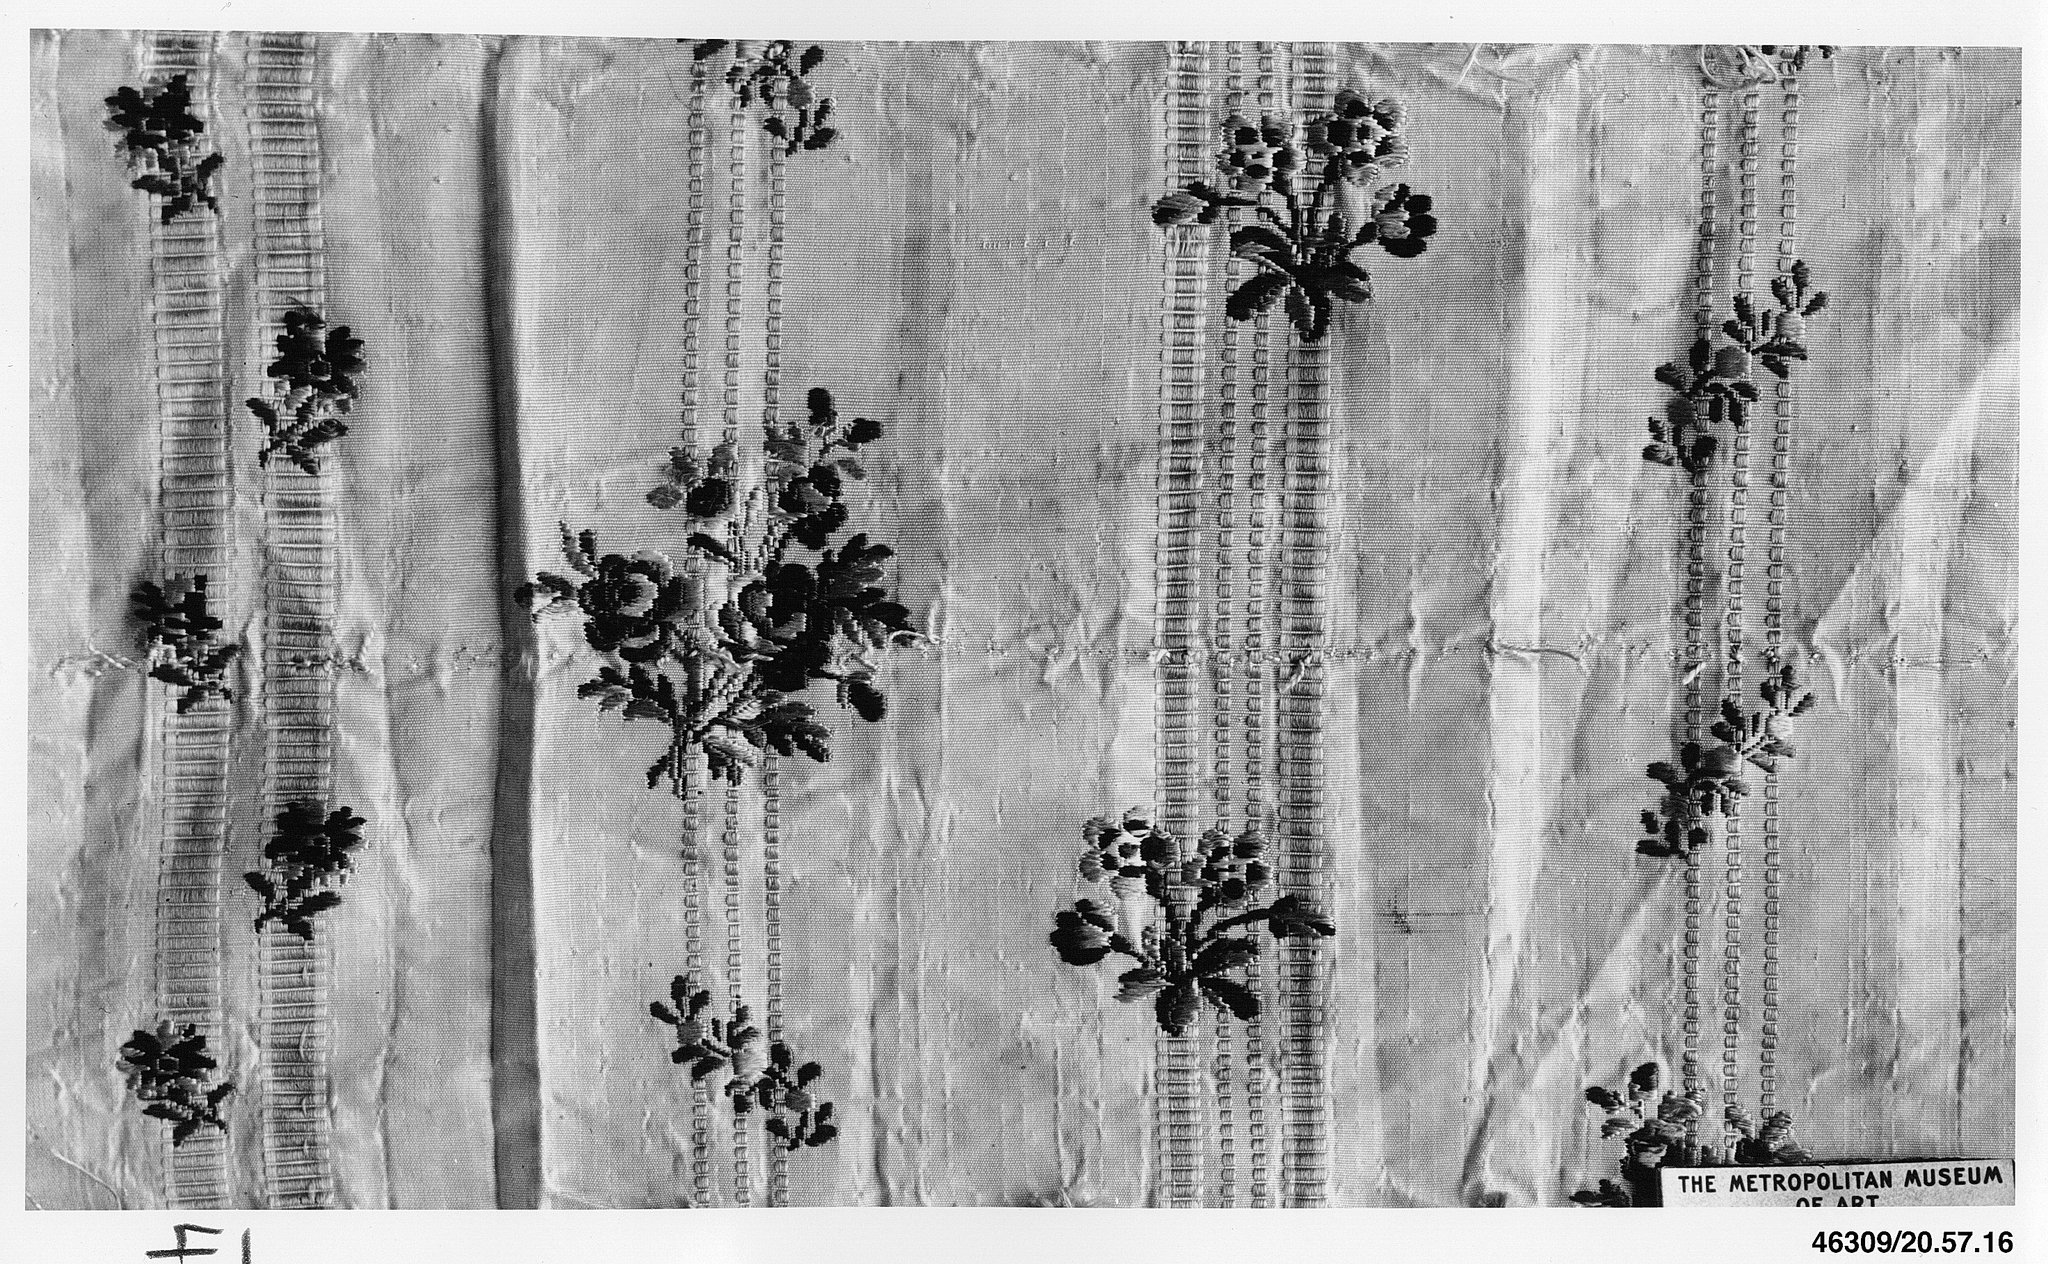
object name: piece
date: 1775-1800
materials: silk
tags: flowers,leaves